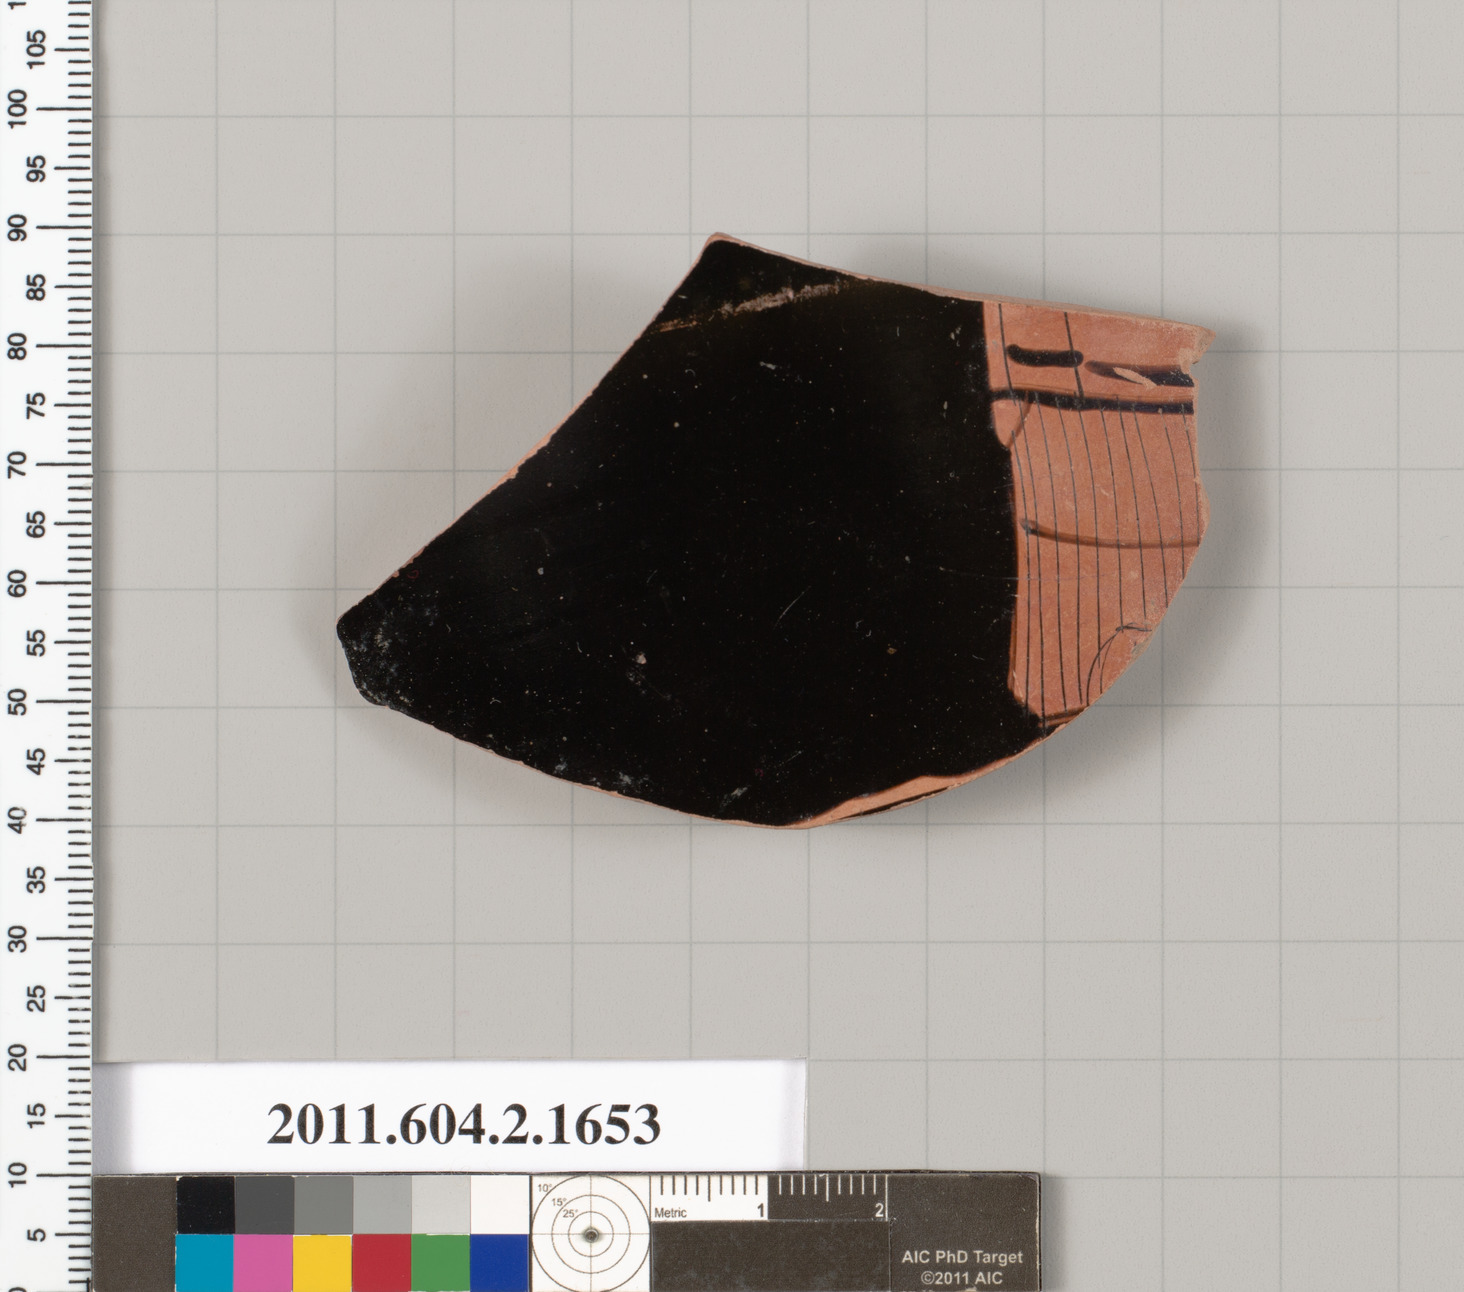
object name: skyphos fragment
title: Terracotta fragment of a skyphos (deep drinking cup)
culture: greek, attic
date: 450-426 BCE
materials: terracotta